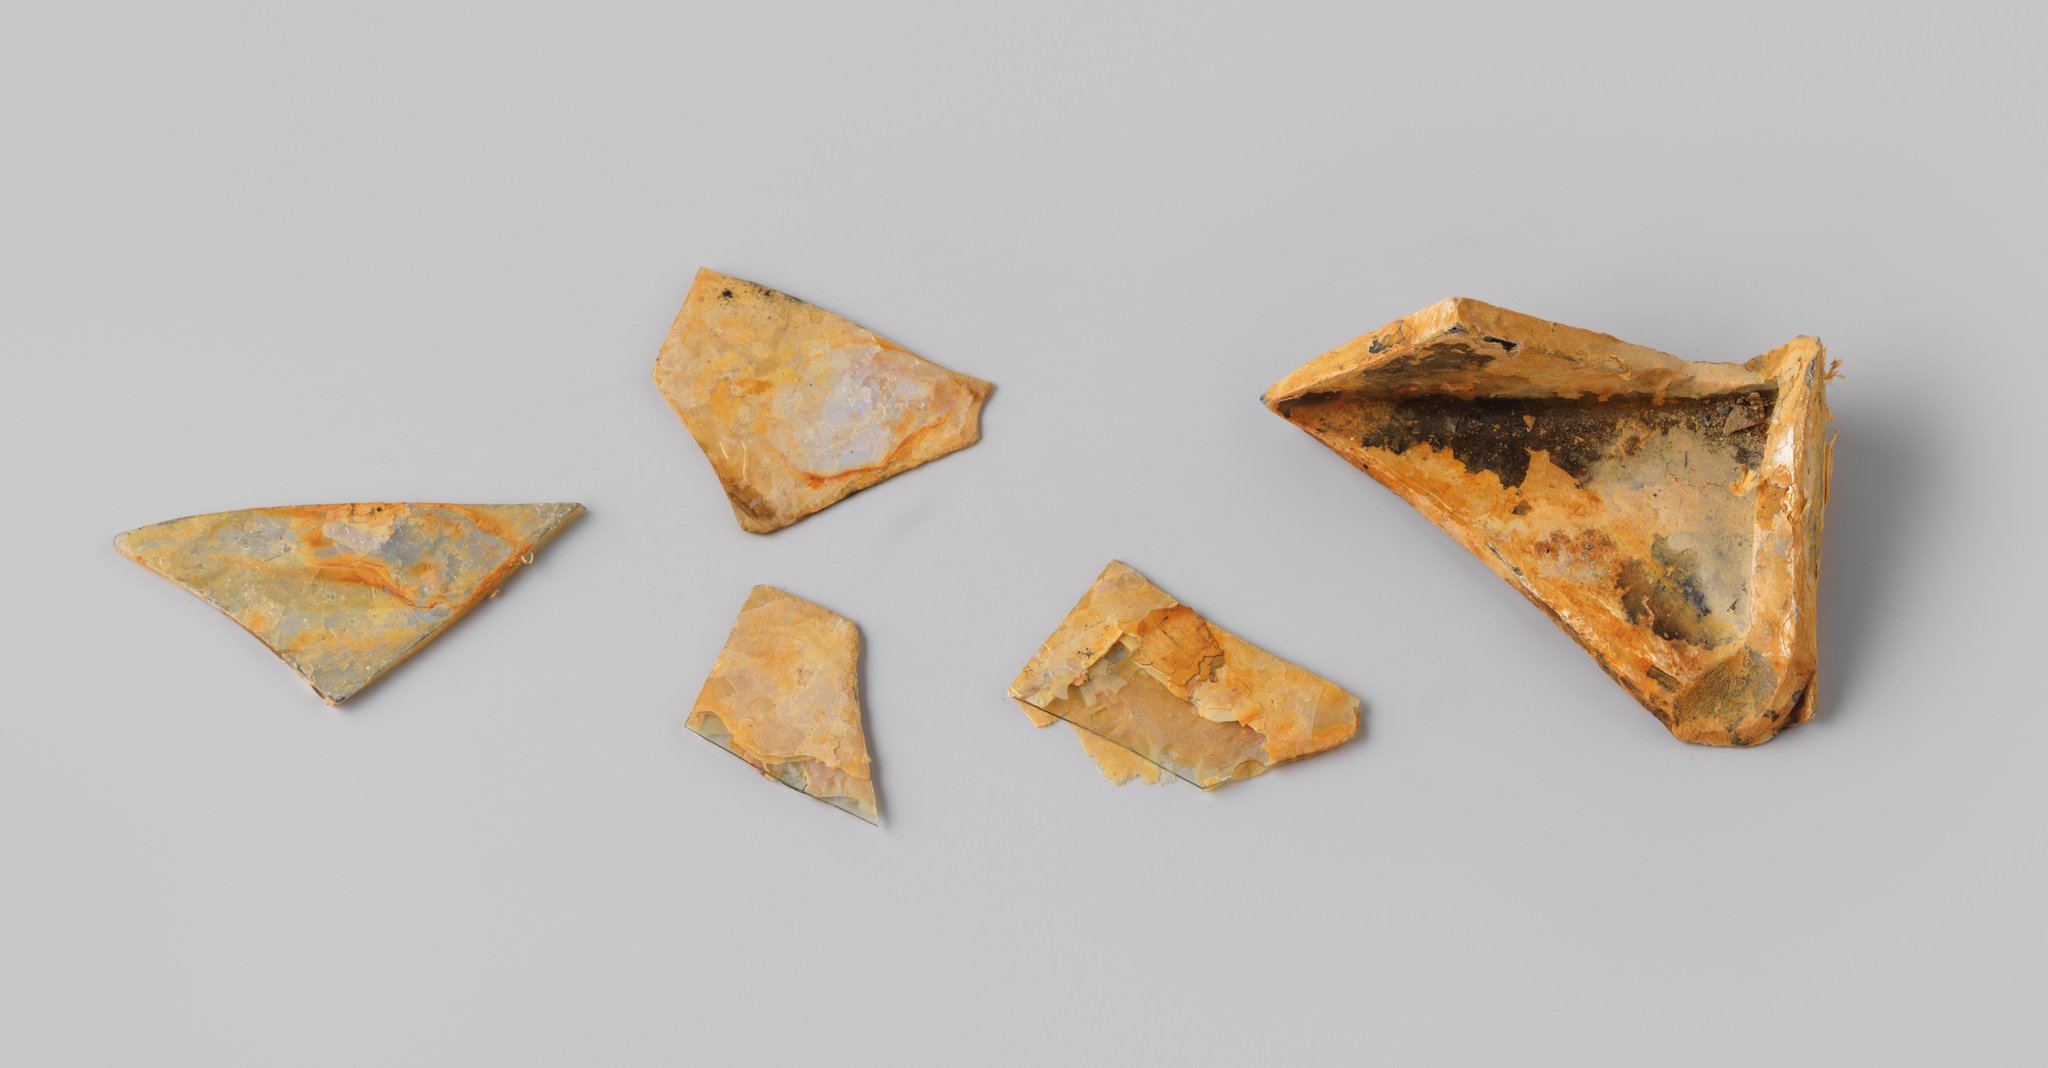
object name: sherd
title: Scherven van kelderflessen uit het wrak van de Oost-Indiëvaarder 't Vliegend Hart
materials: glass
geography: middelburg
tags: 't vliegend hart (schip), verenigde oostindische compagnie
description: Scherven van vierkante kelderflessen. Geelbruin gekleurd, oorspronkelijk was het glas groen. Case bottle.